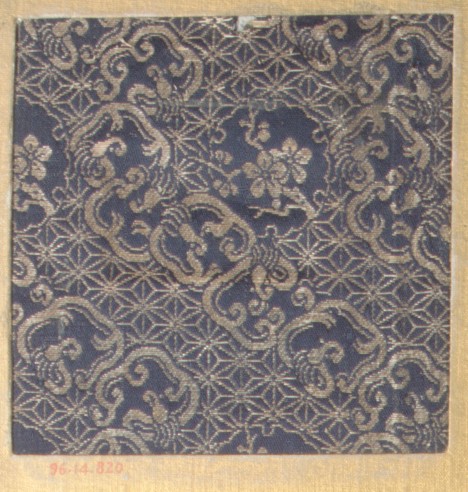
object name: piece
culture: japanese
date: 1701-1900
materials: metal thread, silk